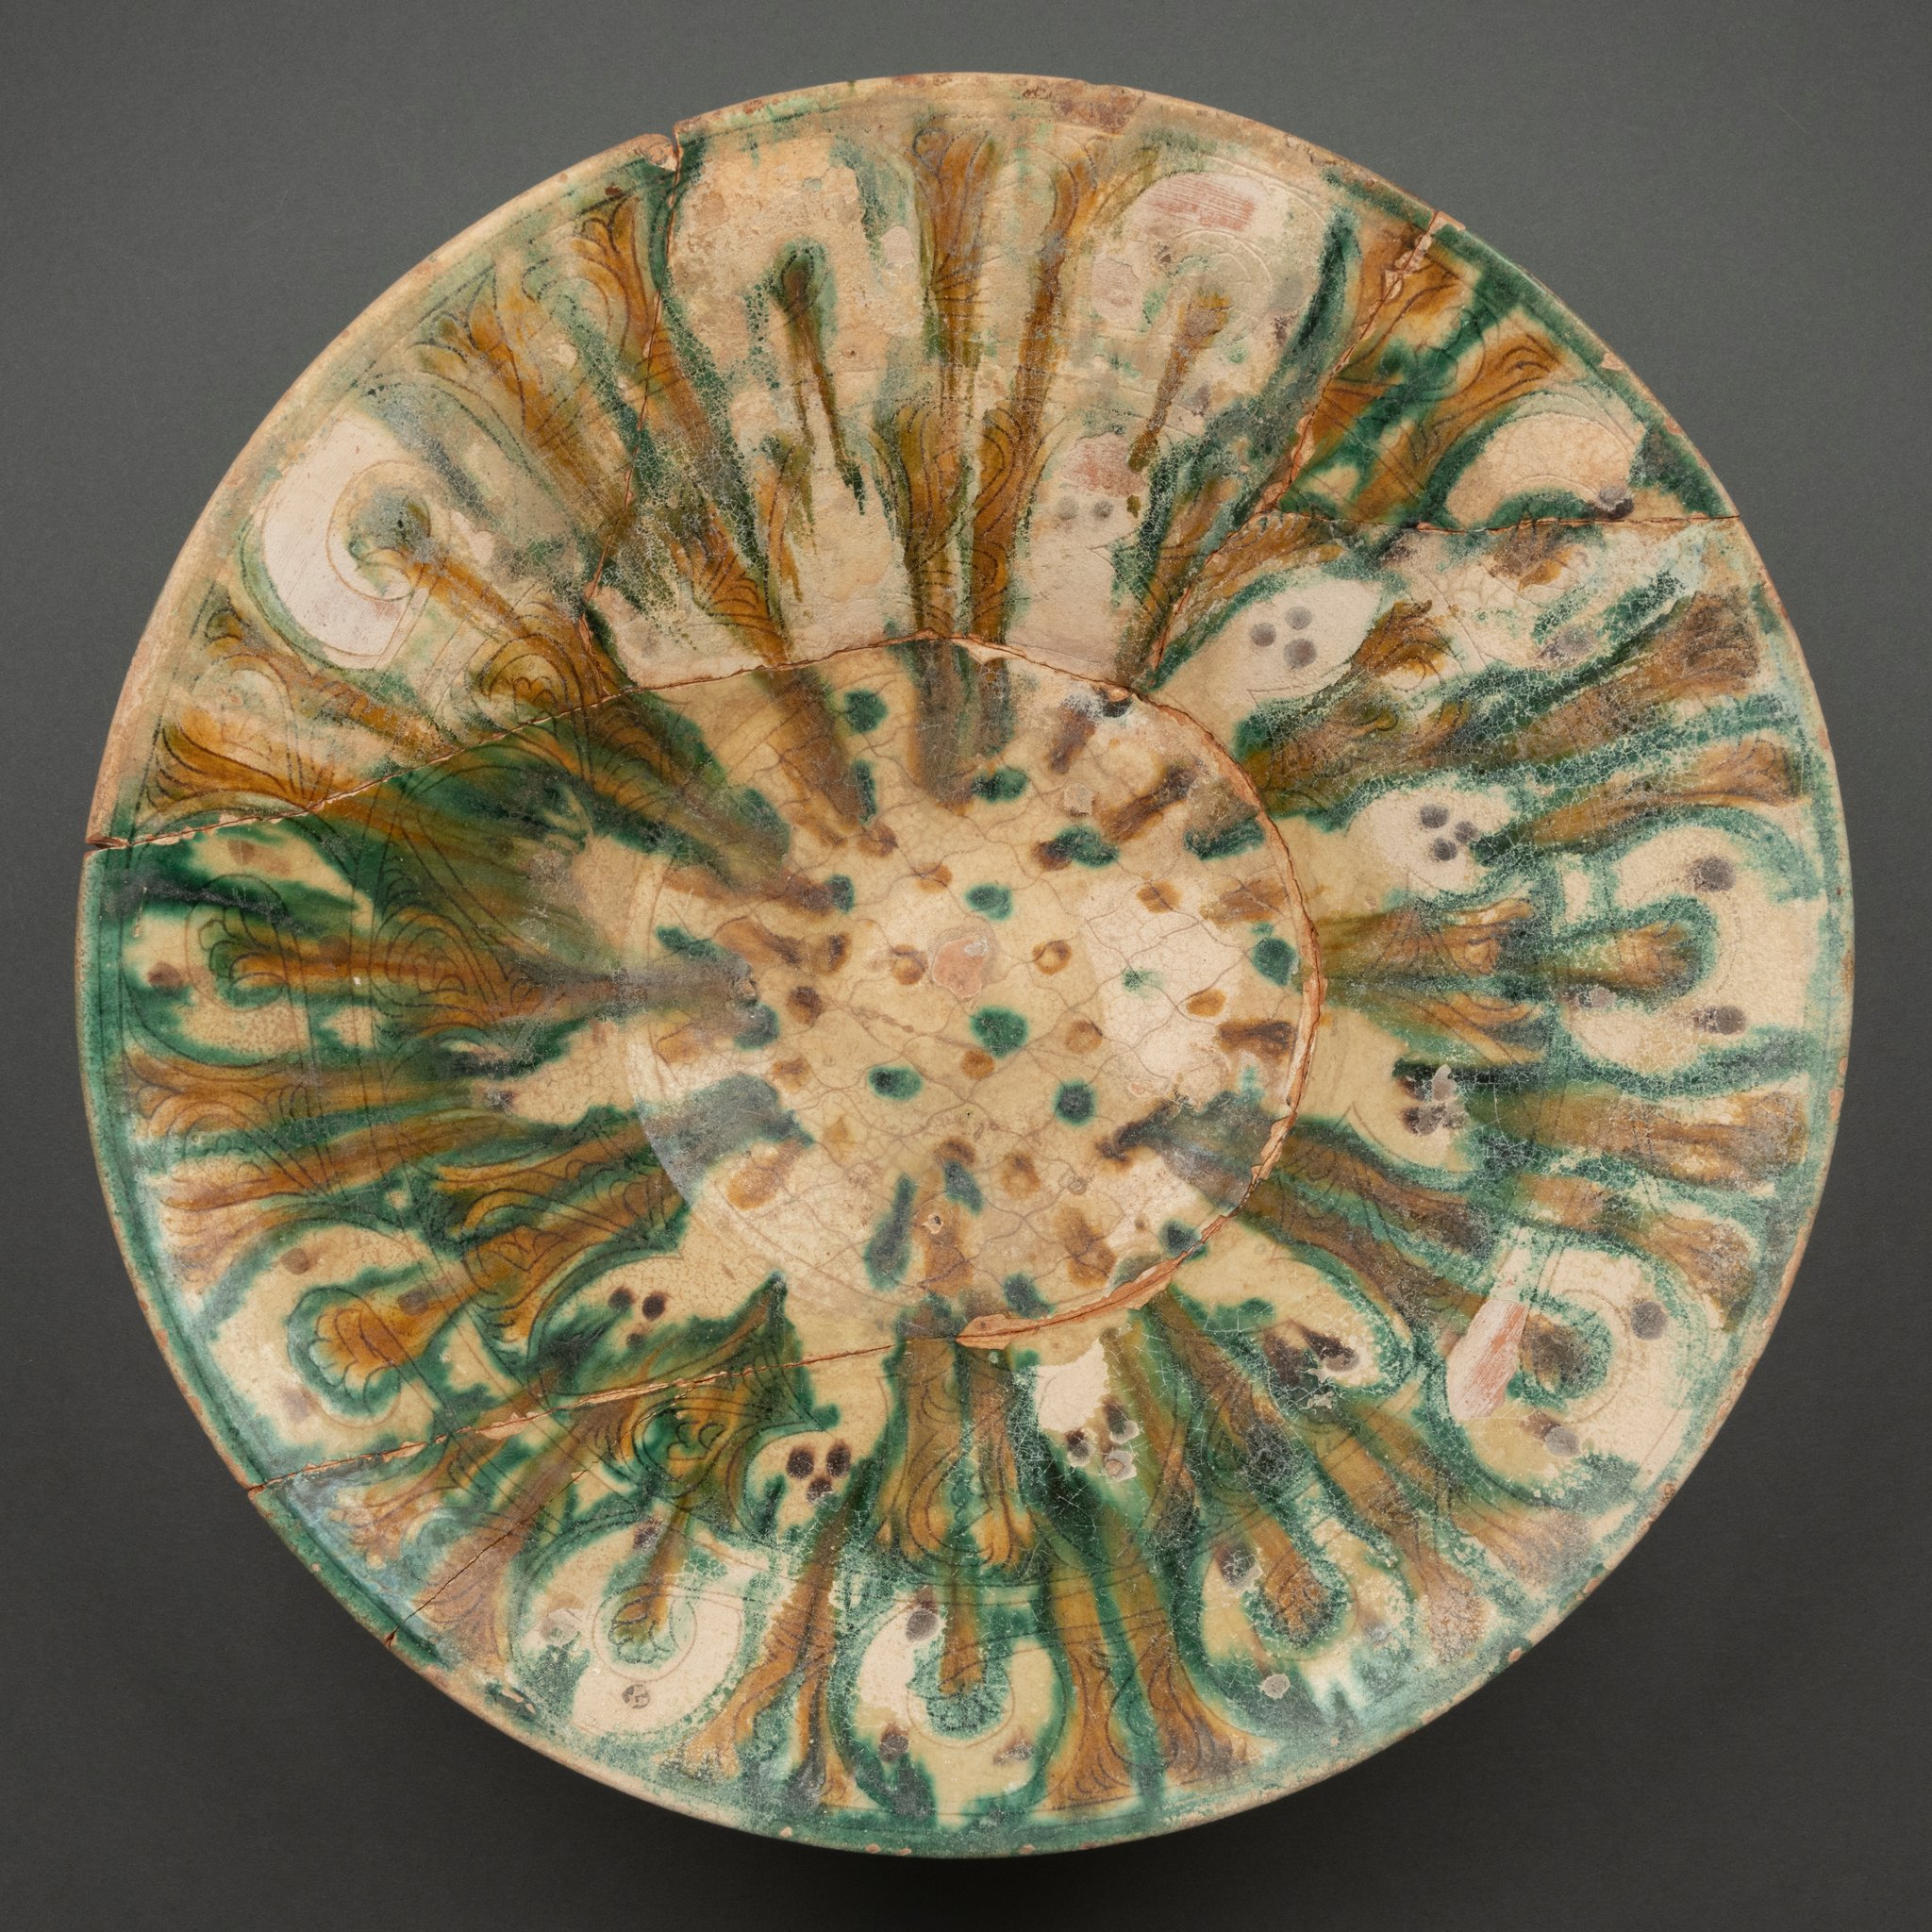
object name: bowl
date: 801-1000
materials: earthenware, glaze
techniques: incising, polychrome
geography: iran